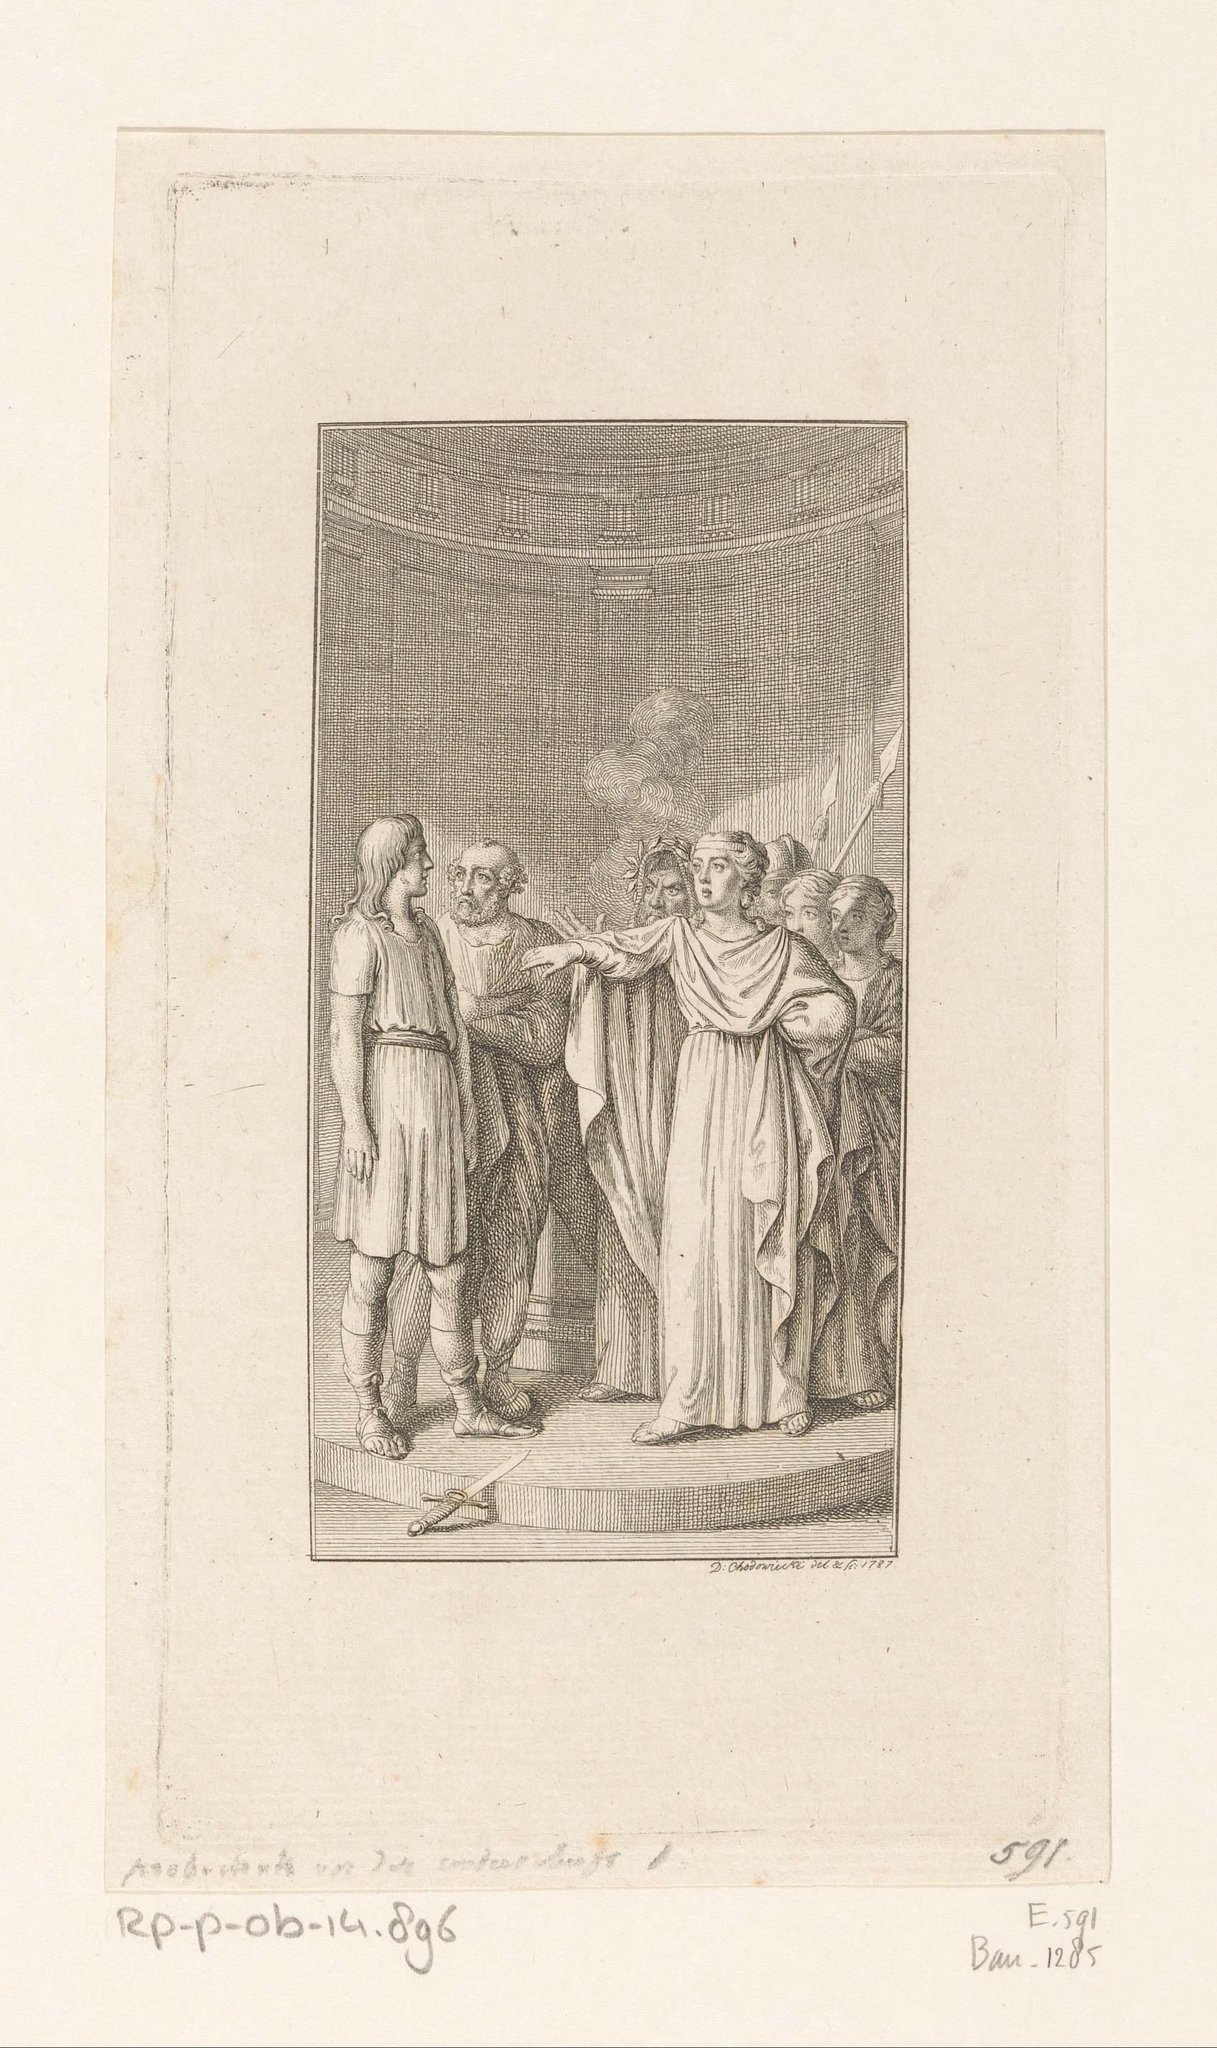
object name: print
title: Merope roept het volk en de priesters op tot een eerlijk proces voor Aegisth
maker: daniel nikolaus chodowiecki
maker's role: draughtsman, print maker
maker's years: 1726-1801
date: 1787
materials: paper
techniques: etching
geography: berlin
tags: literature, (story of) merope, wife of cresphontes, hacking and thrusting weapons: sword, priest ~ non-christian religions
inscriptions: collector's mark: Lugt 2228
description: Vervaardigd voor Gotter's vertelling 'Merope'. Prent uit: Gedichte von Friedrich Wilhelm Gotter. Gotha bei Carl: Wilhelm Ettinger, 1788, dl. 2.